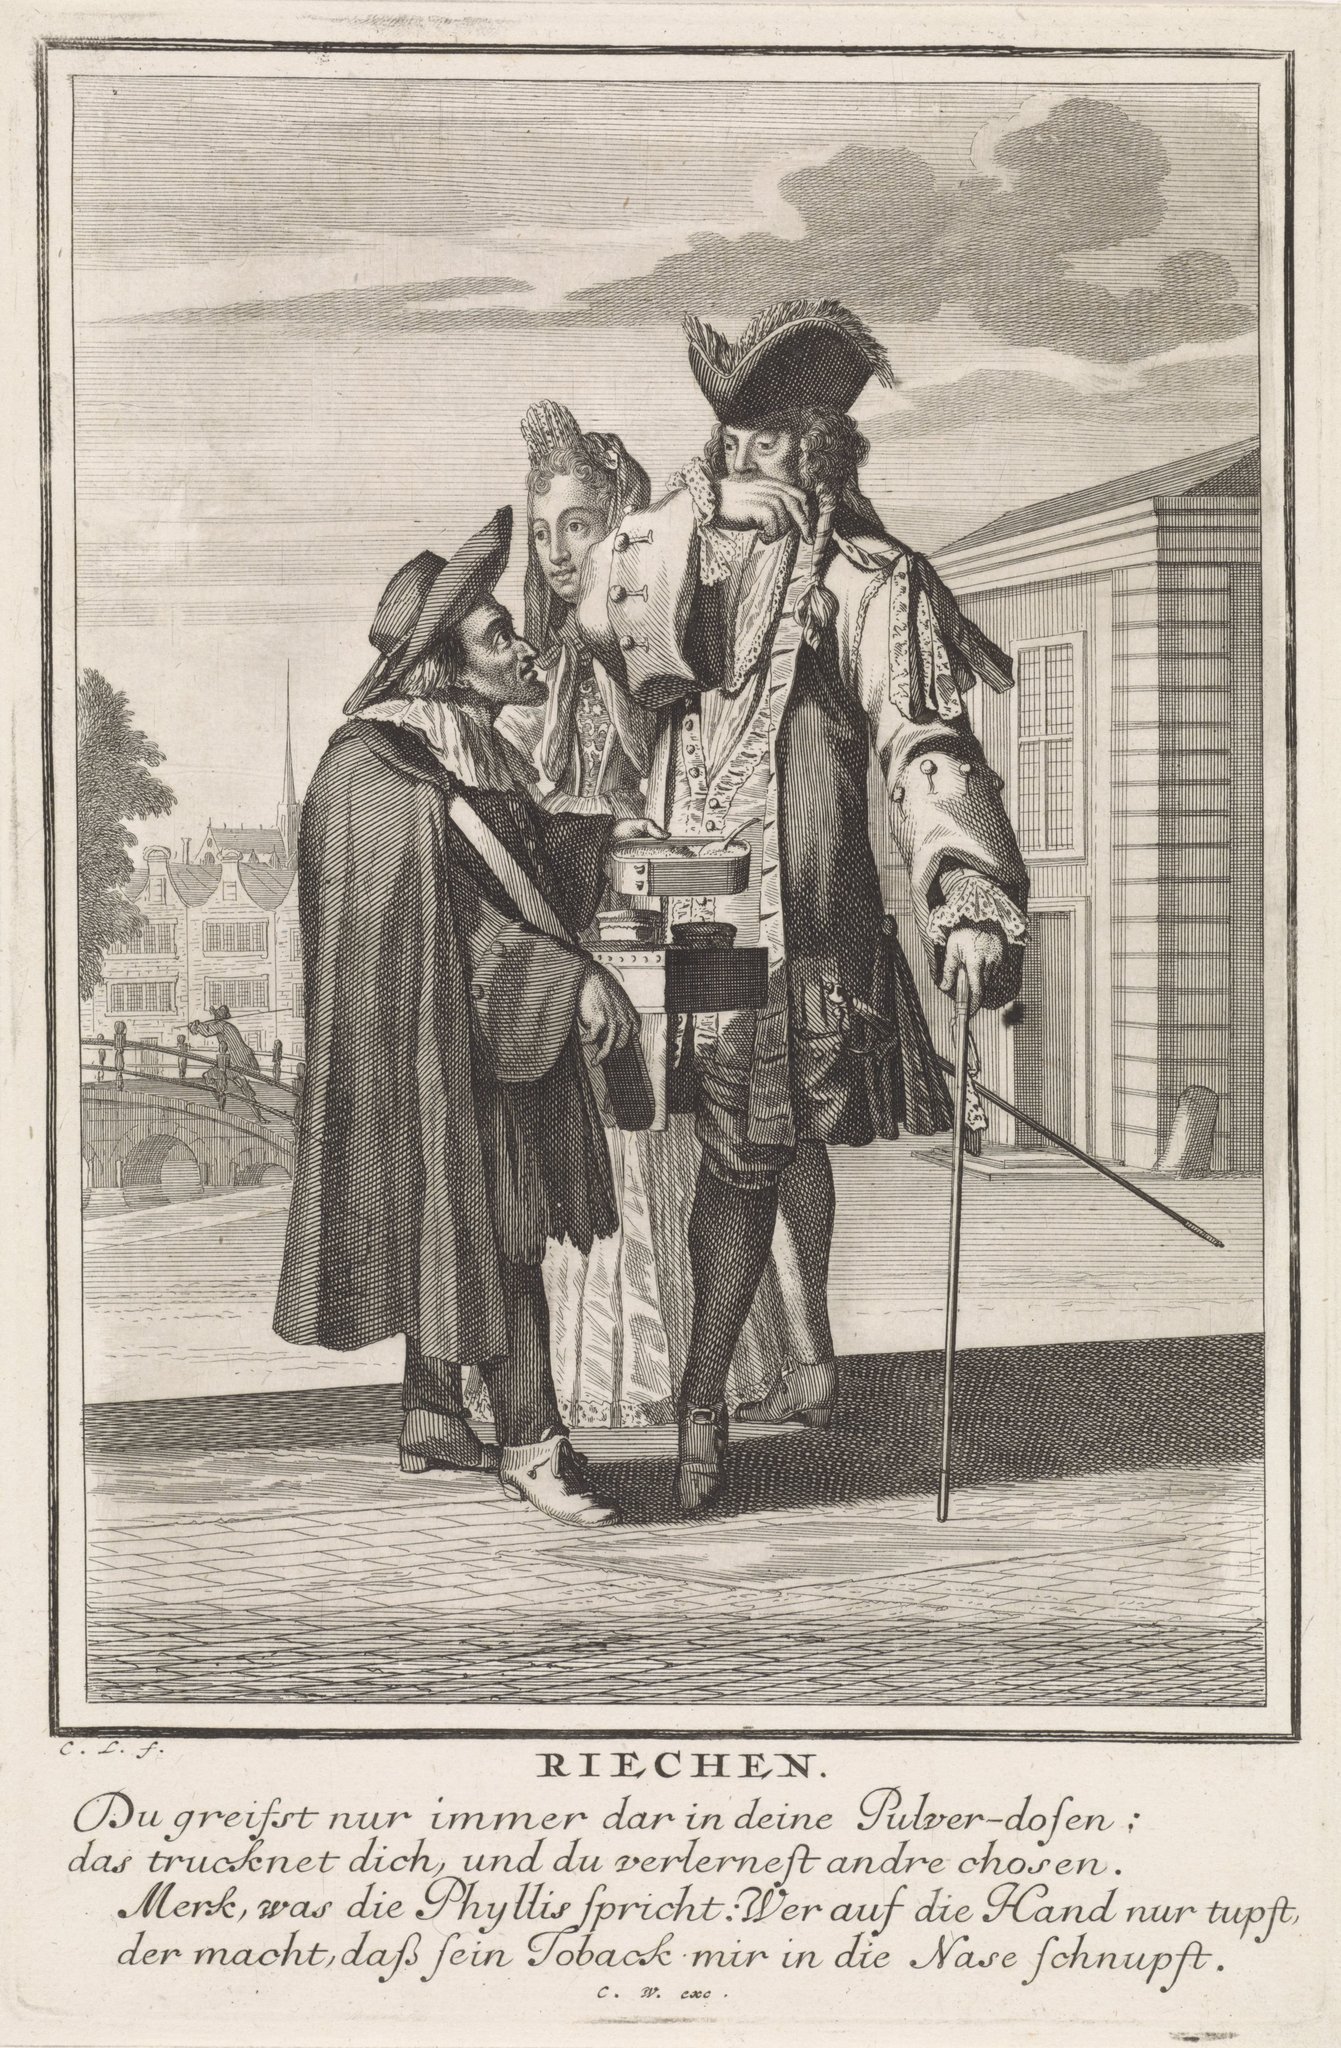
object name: print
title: Reuk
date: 1698-1702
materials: paper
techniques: engraving, etching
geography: nuremberg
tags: smell, smelling (one of the five senses), street-trader, street, snuff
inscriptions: collector's mark: Lugt 2228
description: Een adelijk paar wandelt op straat en worden aangeproken door een straatventer. De edelman houdt zijn hand tegen zijn neus om wat snuiftabak te snuiven die de venter aanbiedt. De prent heeft een Duits onderschrift van vier regels over het zintuig reukzin.